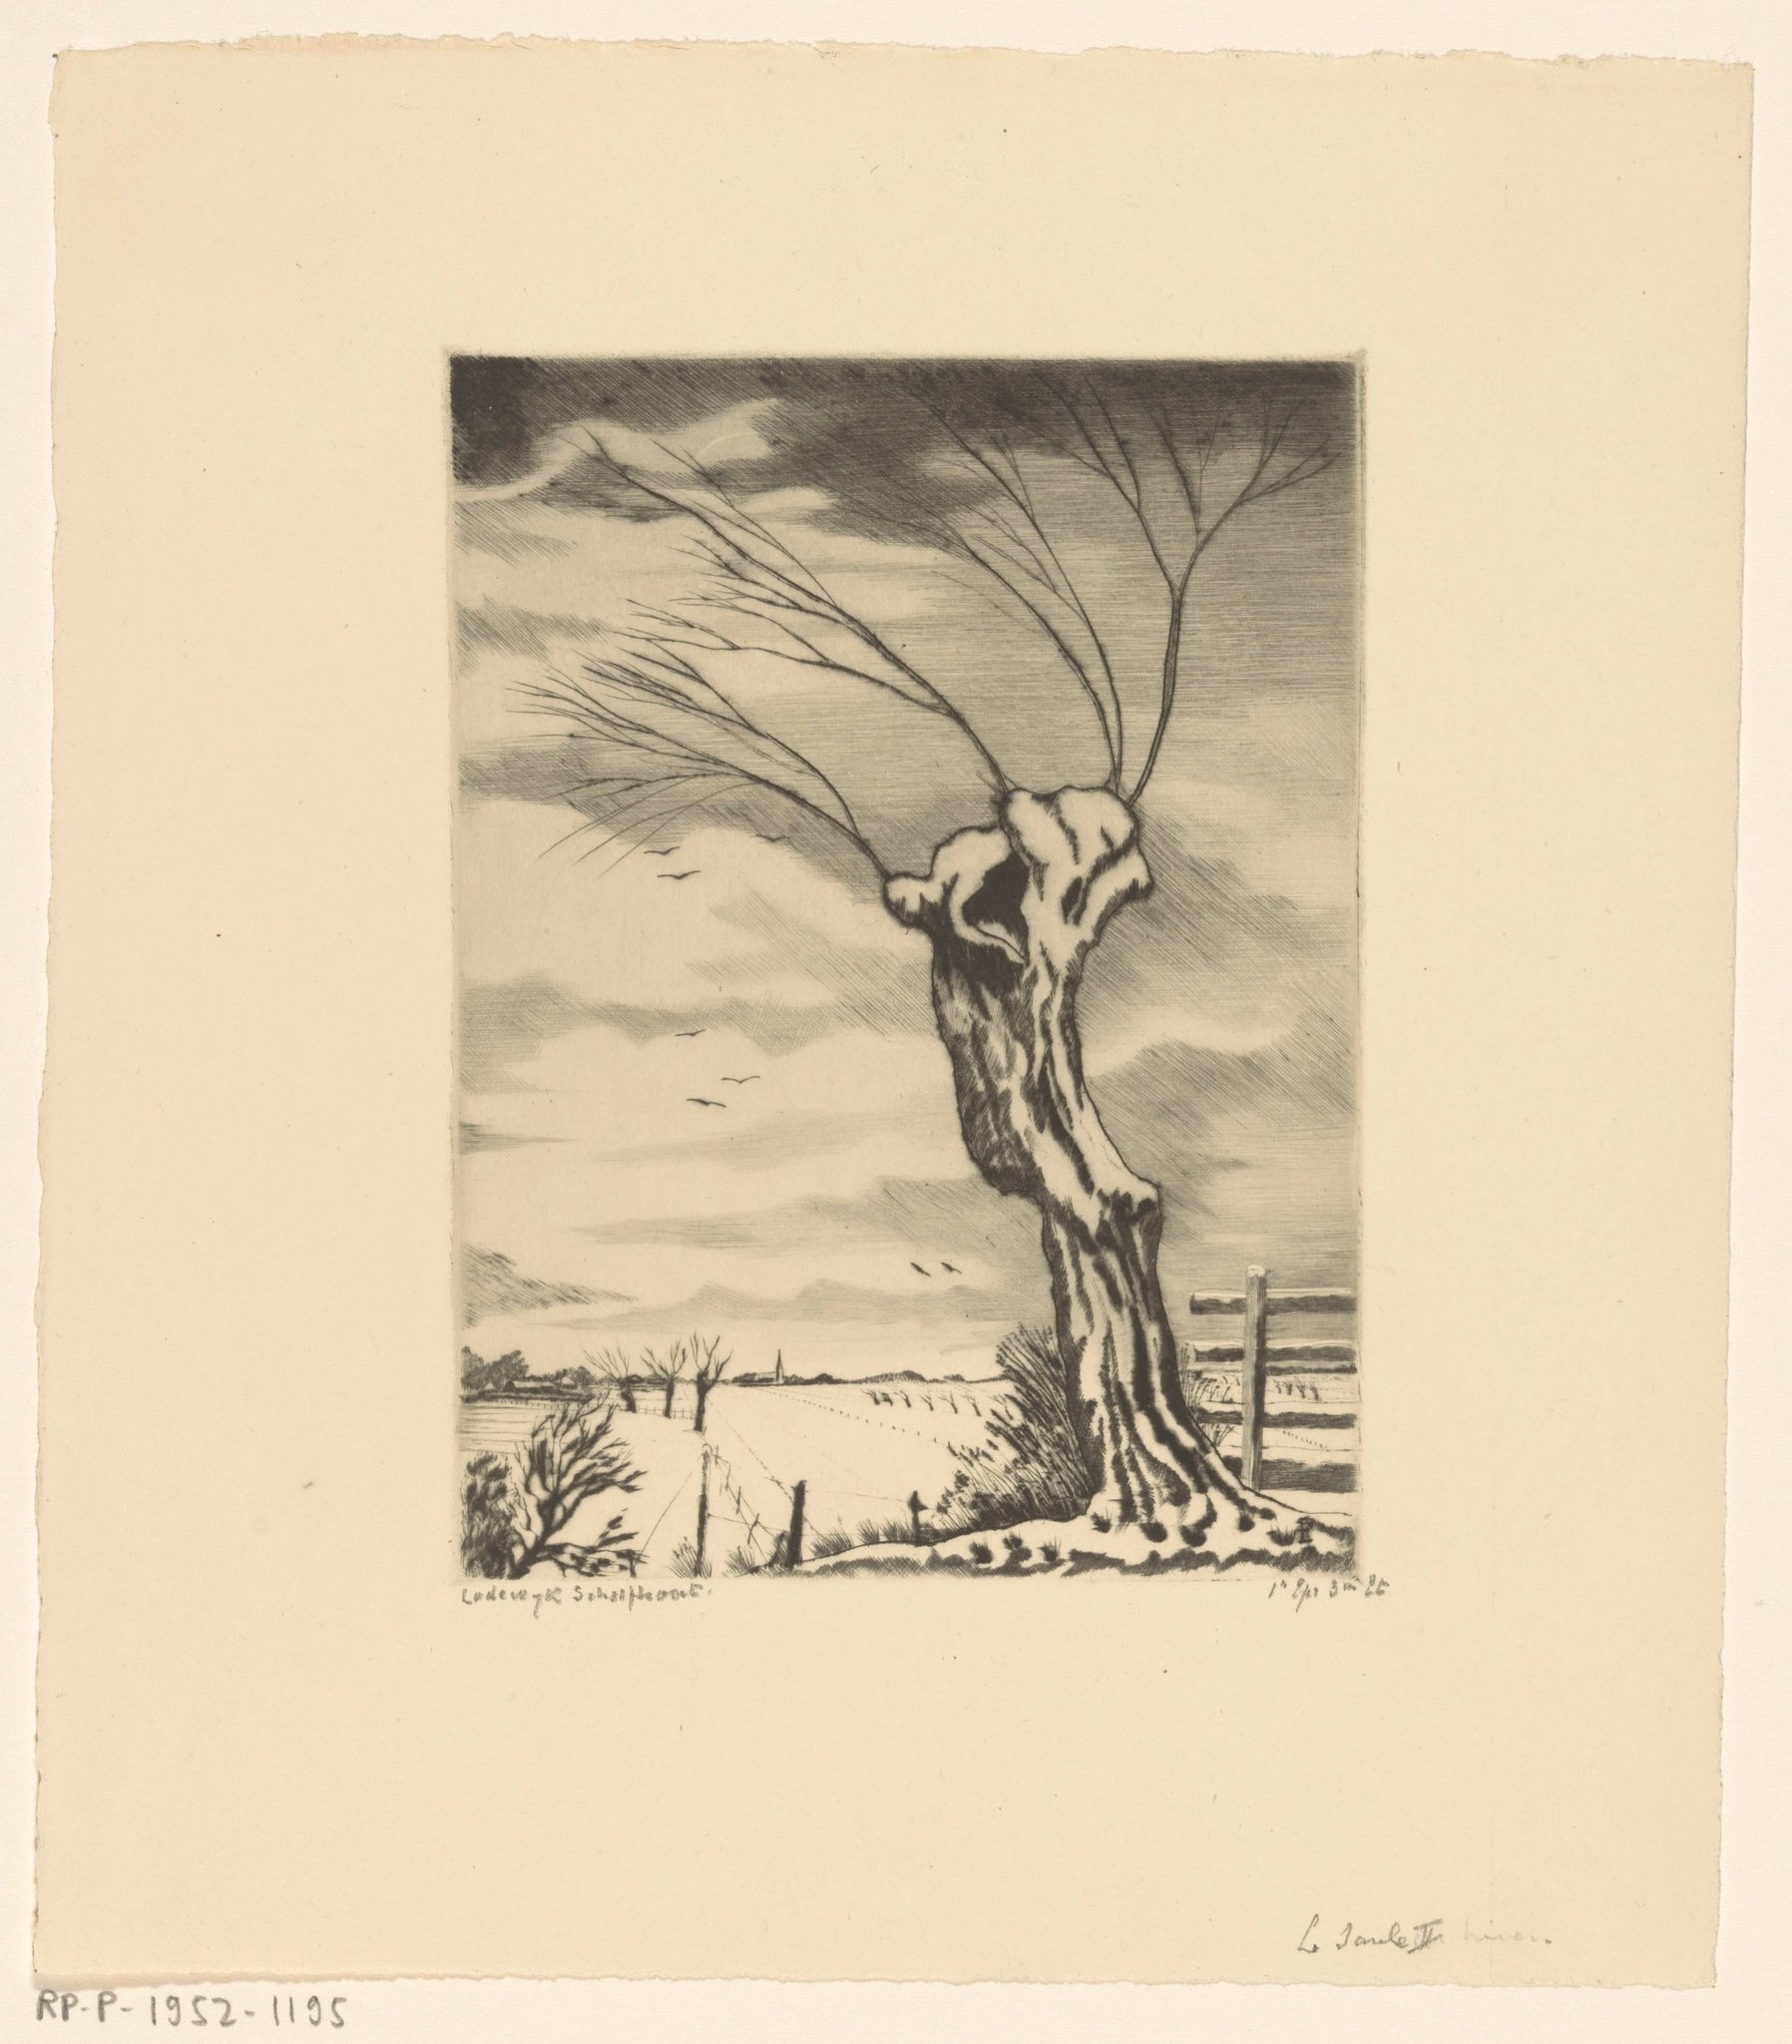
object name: print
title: Le Saule II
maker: lodewijk schelfhout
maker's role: draughtsman, print maker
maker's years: 1881-1943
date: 1940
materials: paper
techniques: drypoint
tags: snow, trees: willow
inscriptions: collector's mark: Lugt 2228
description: Een knotwilg naast een hek in een besneeuwd landschap met akkers.